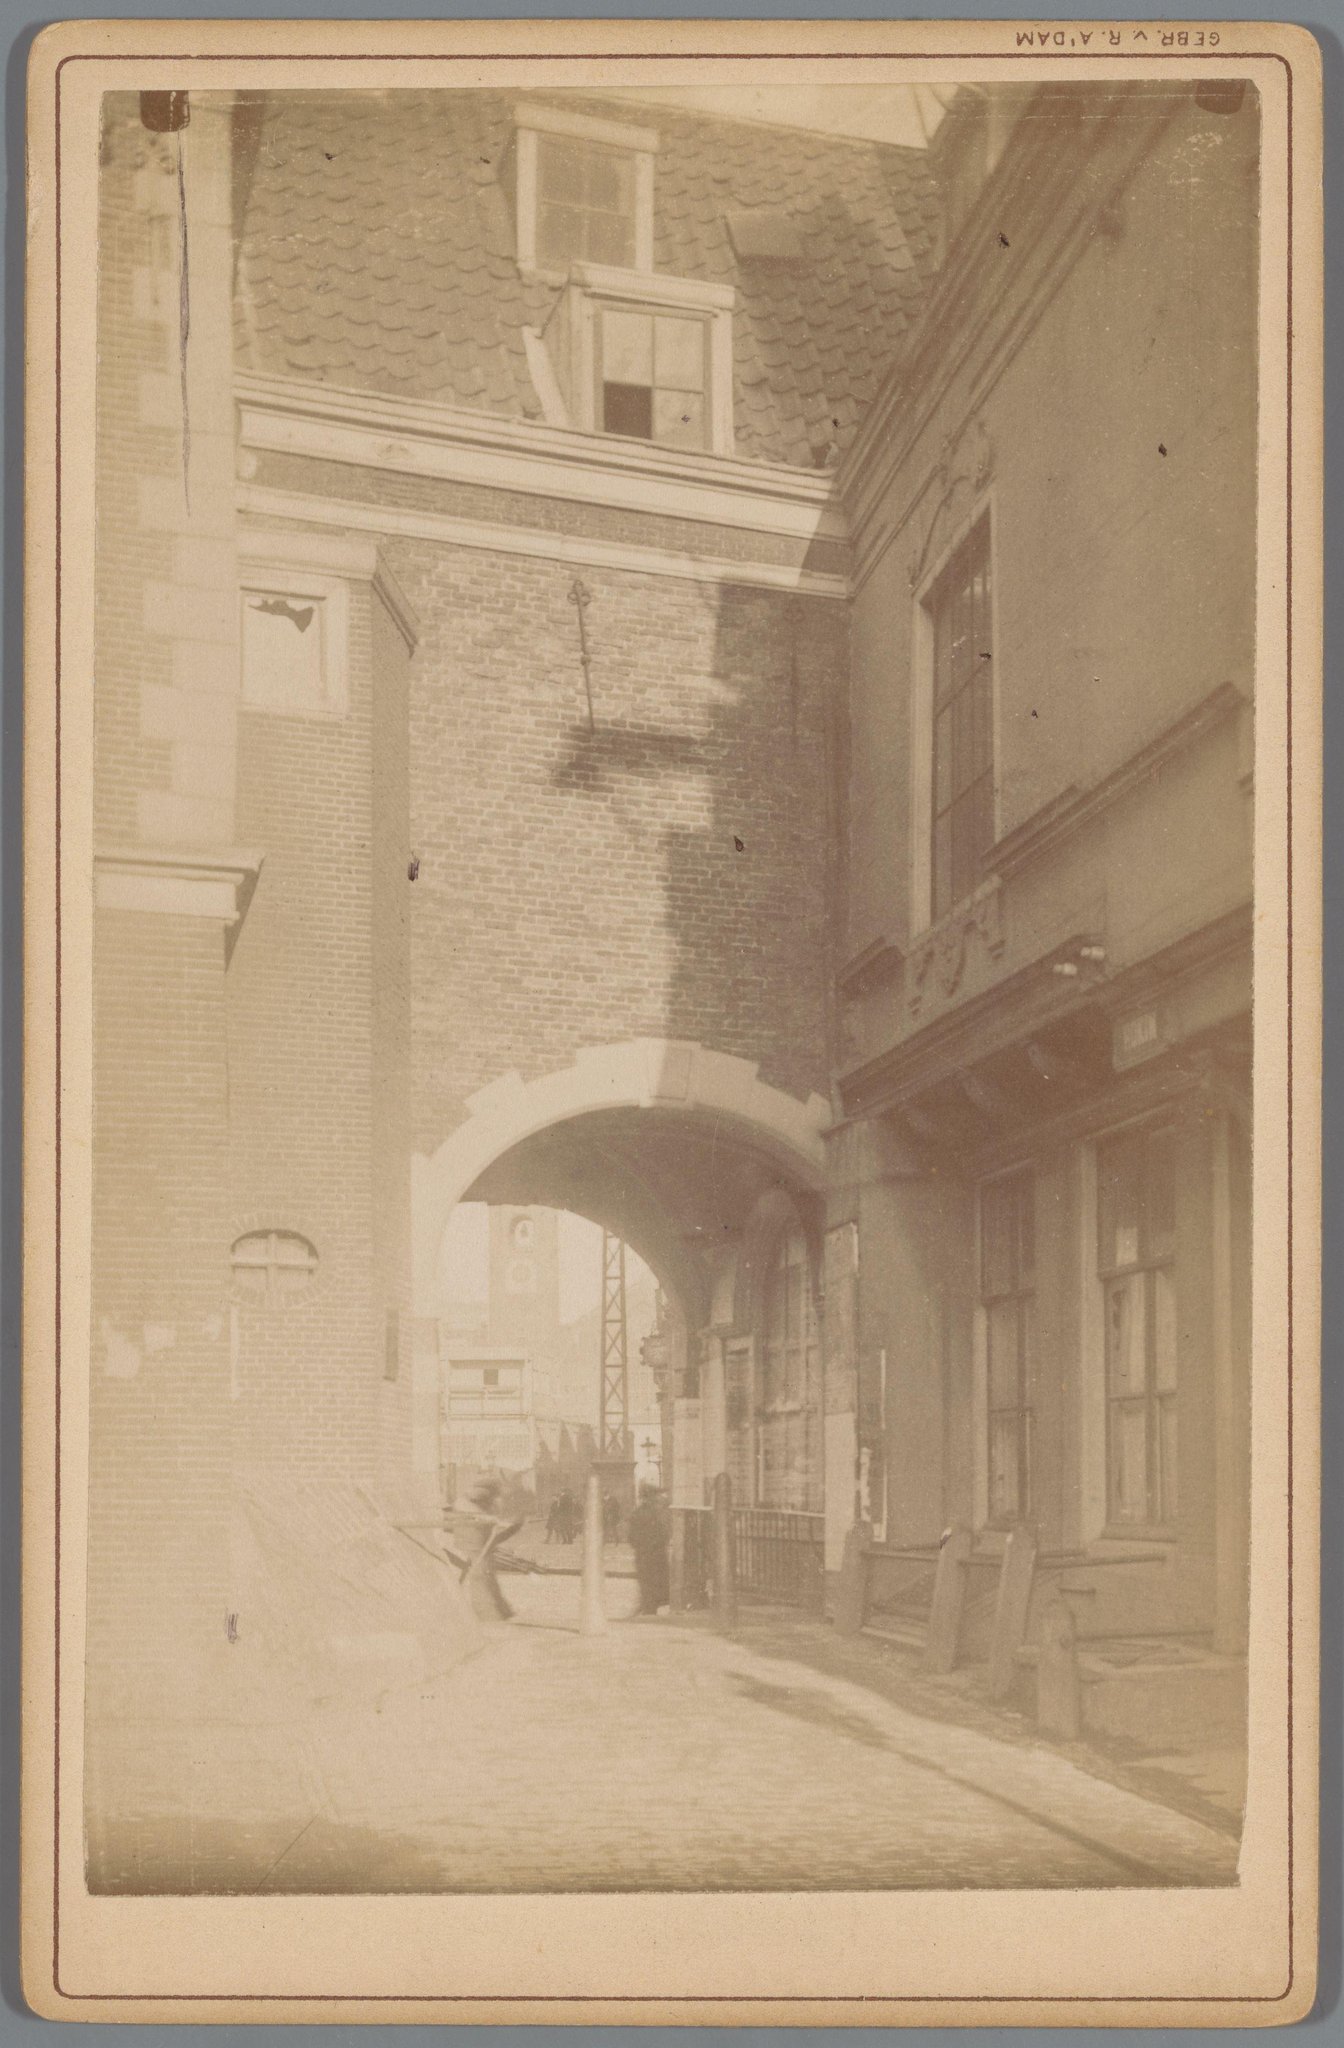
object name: cabinet photograph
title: Gezicht op het Beurspoortje in Amsterdam met een doorkijk naar de Dam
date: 1860-1880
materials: cardboard, photographic support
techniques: albumen print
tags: gate, entrance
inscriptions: name: ‘Vosmaer’, inscription: ‘Het voormalige Oude Beurspoortje ziende naar den Dam. Afgebroken en Vernieuwd.’, number: ‘445’